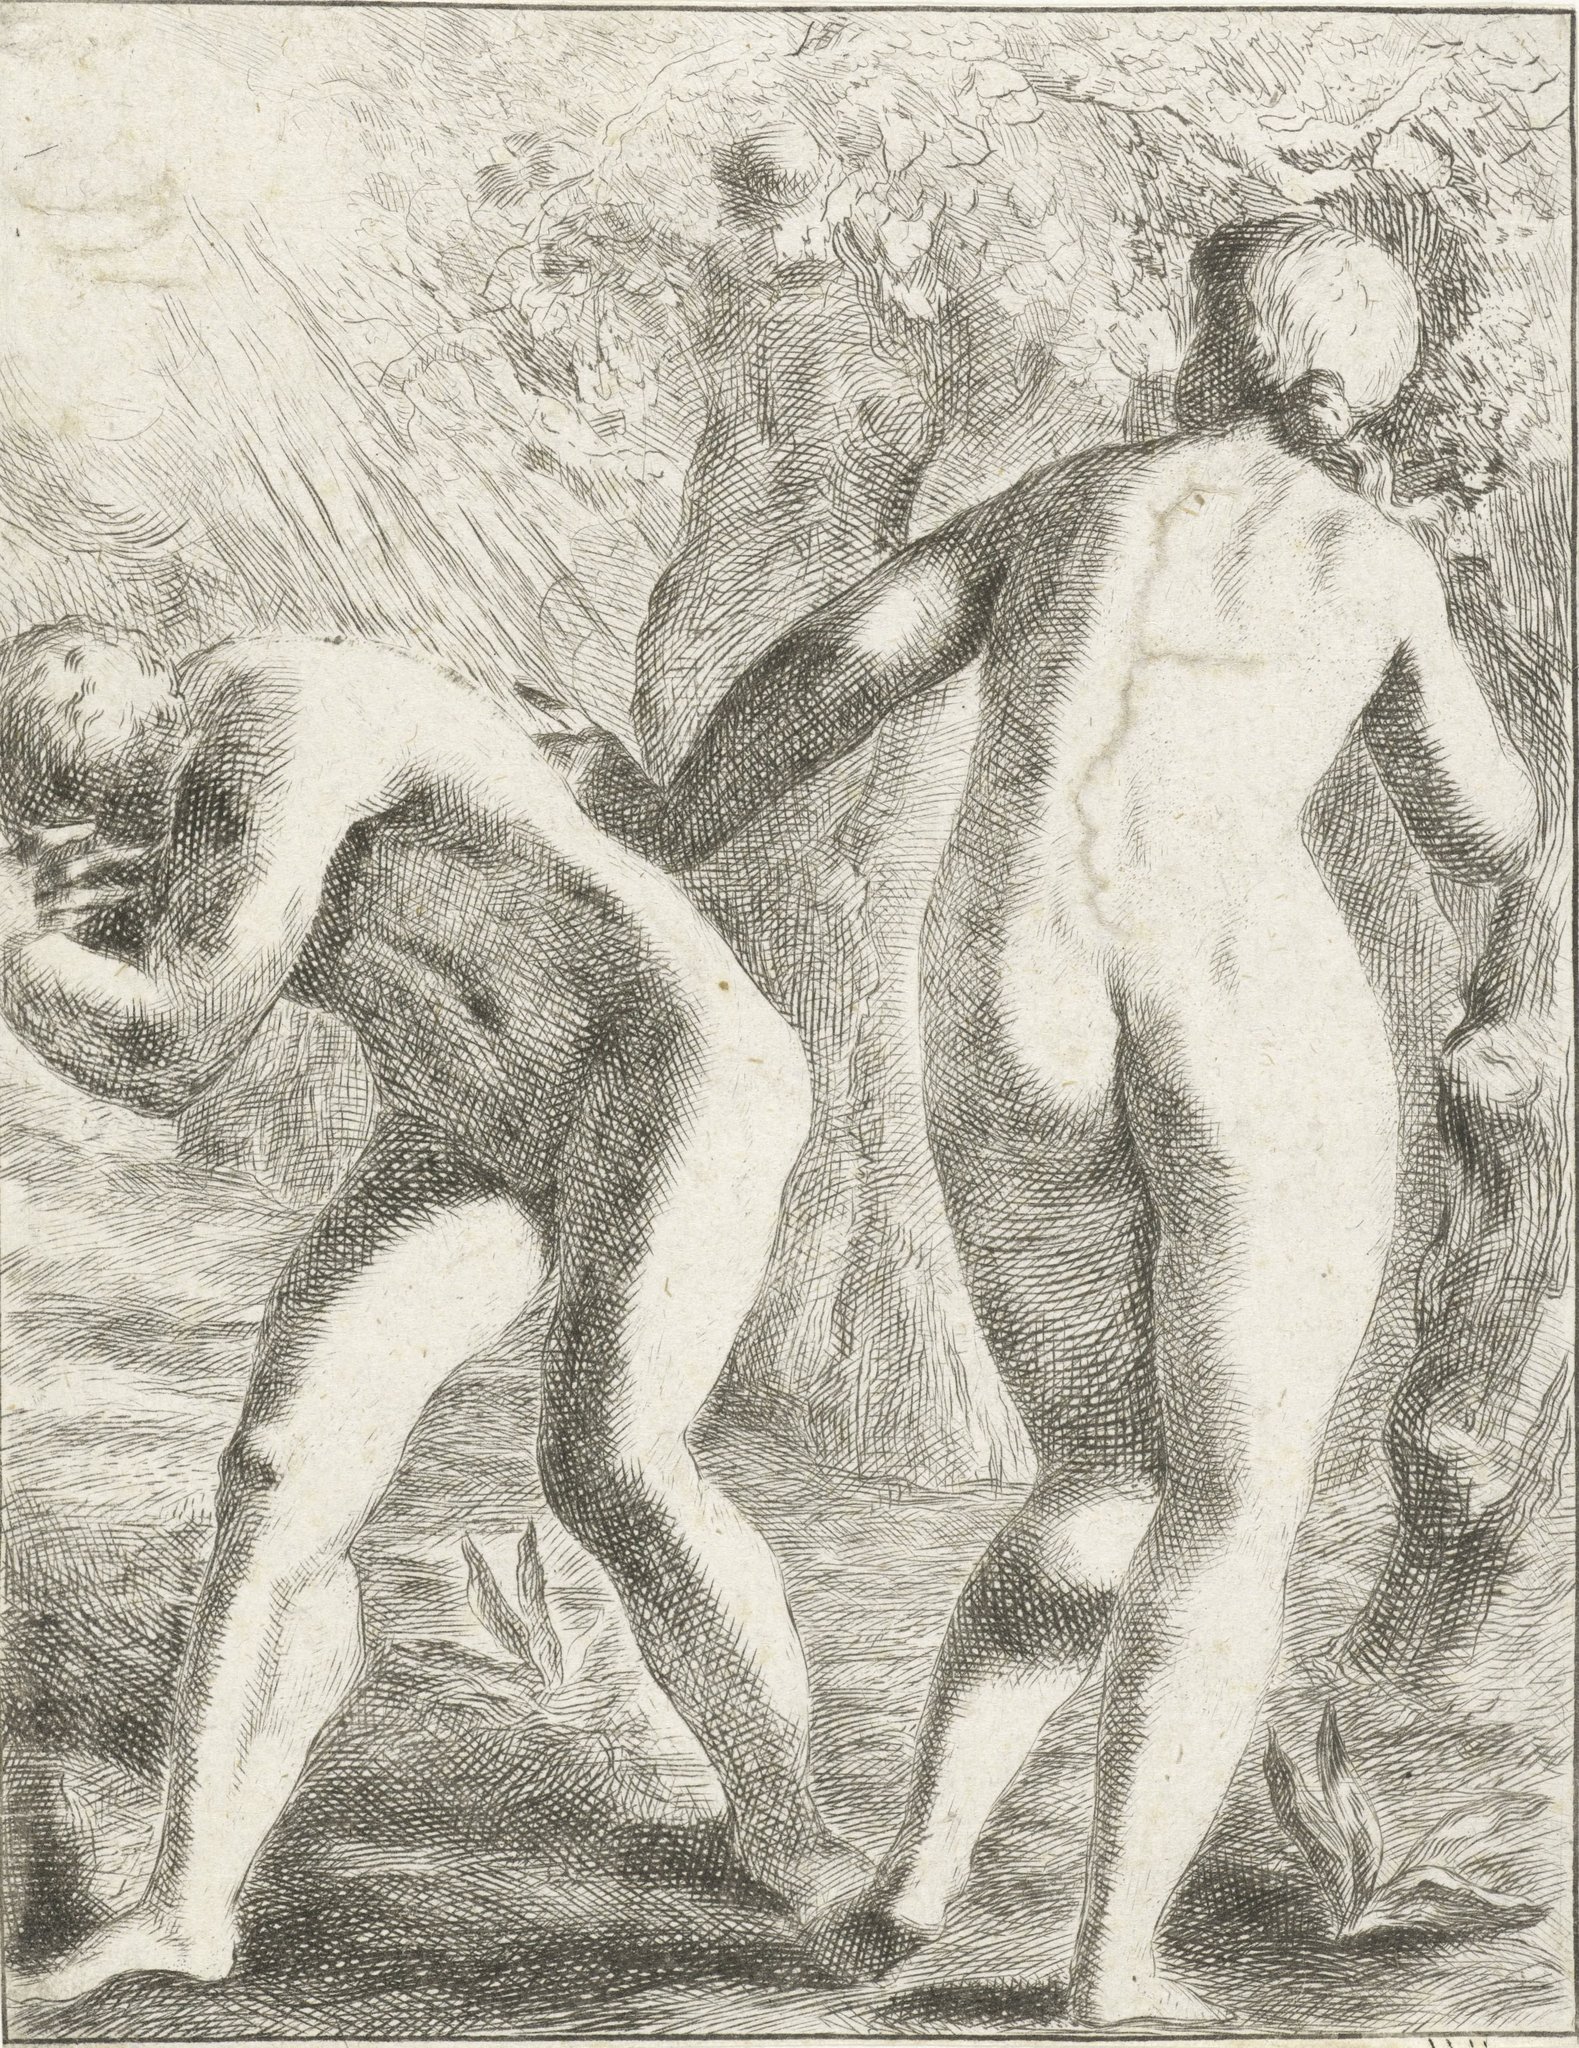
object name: print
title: Expulsion from Paradise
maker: pieter van der plas (ii)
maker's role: print maker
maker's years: 1647-1708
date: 1687-1708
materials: paper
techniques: engraving, etching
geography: northern netherlands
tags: expulsion of adam and eve from paradise (genesis 3:22-24)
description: Adam en Eva verlaten naakt en beschaamd de hof van Eden. Adam bedekt zijn gezicht met zijn handen.